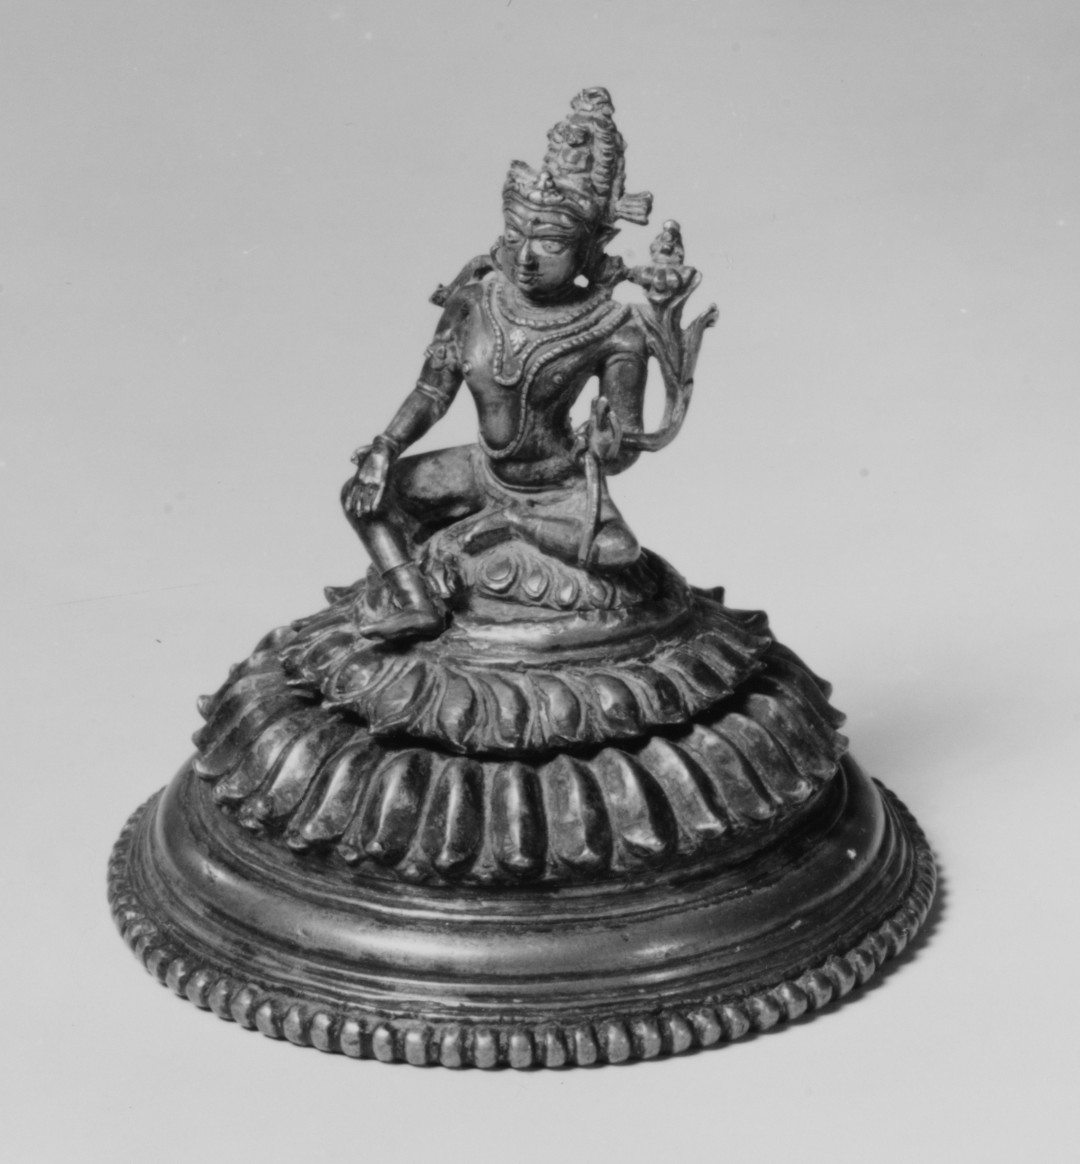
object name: figurine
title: Seated Padmapani, the Lotus-Bearing Bodhisattva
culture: indian, bengal or bangladesh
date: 1101-1200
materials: bronze, copper, silver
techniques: inlay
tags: buddhism,bodhisattvas